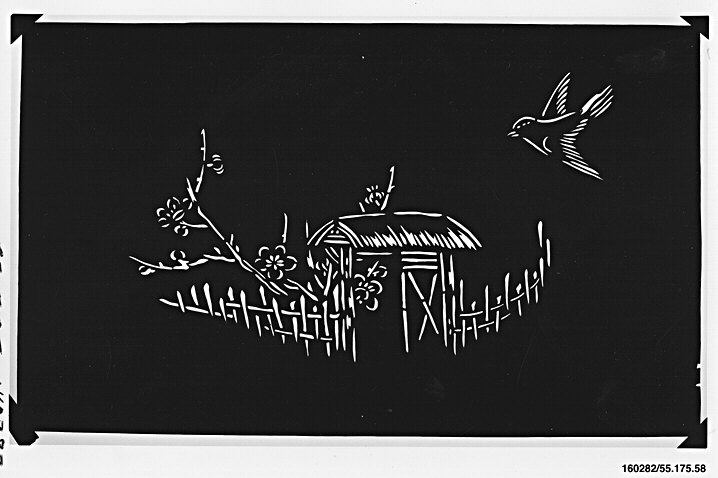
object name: stencil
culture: japanese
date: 1801-1900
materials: paper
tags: birds,gates